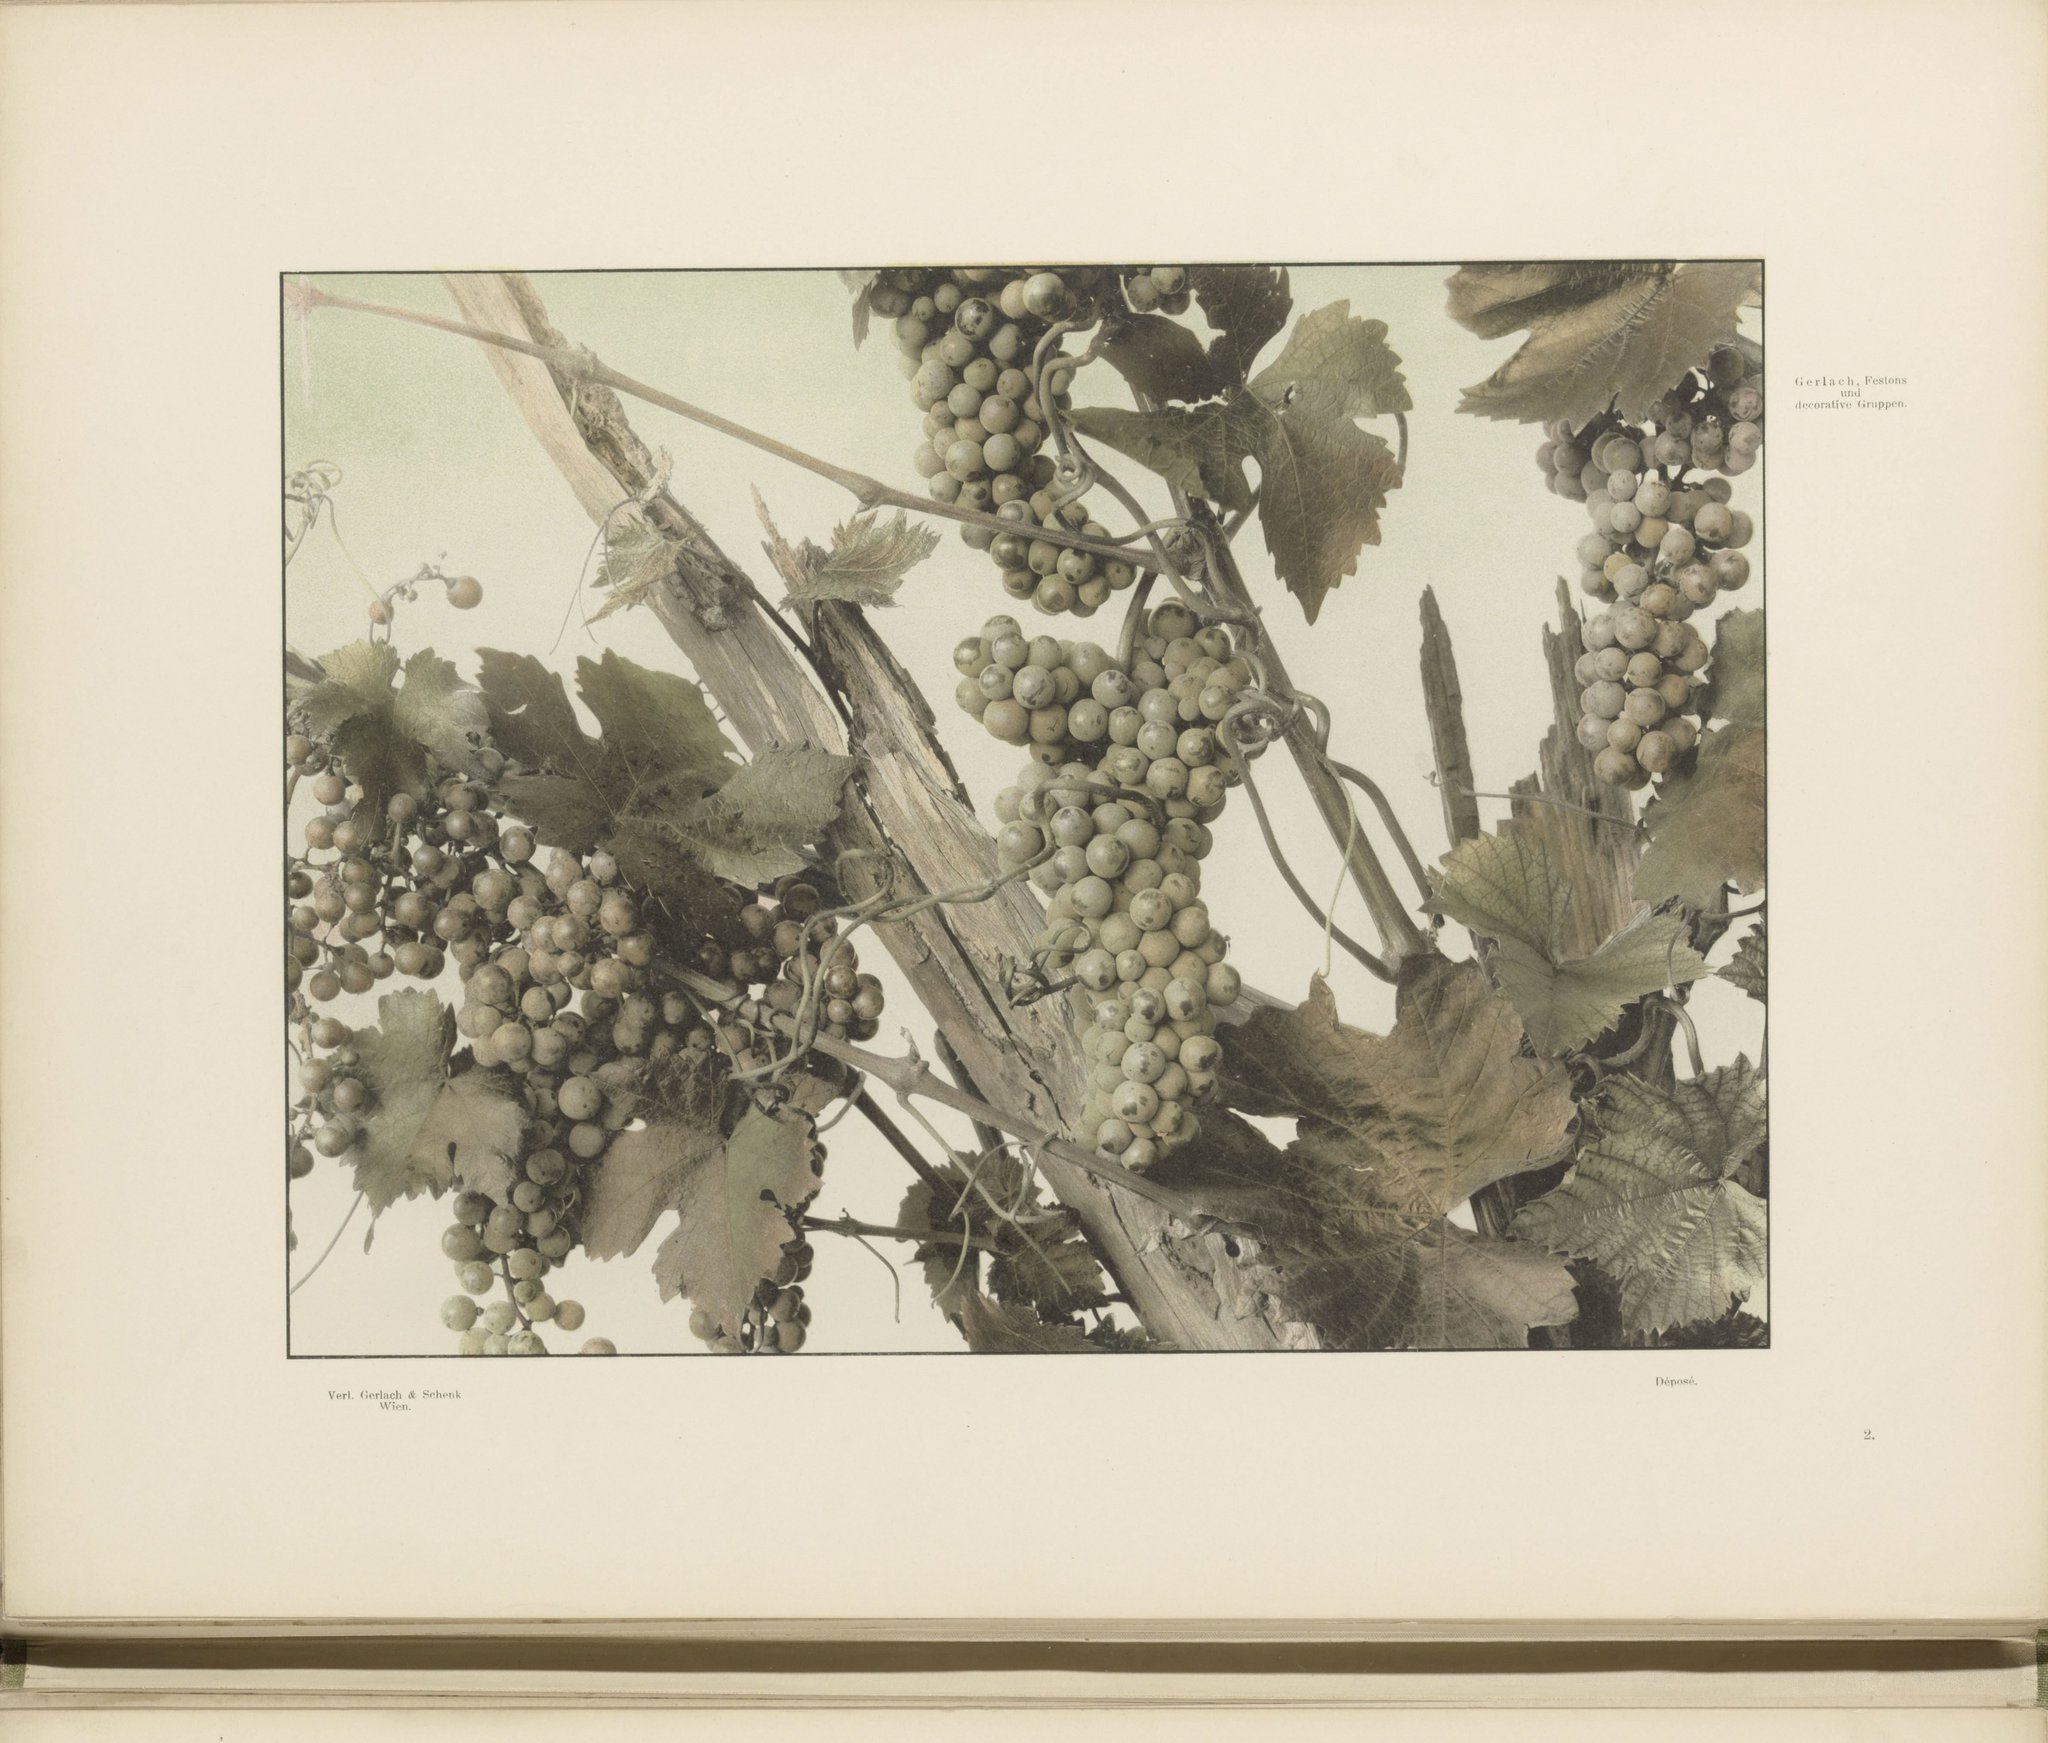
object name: photomechanical print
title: Druivenranken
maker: Anonymous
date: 1887-1897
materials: paper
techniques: photograph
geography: vienna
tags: vine, bunch of grapes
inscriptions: number: ‘2.’